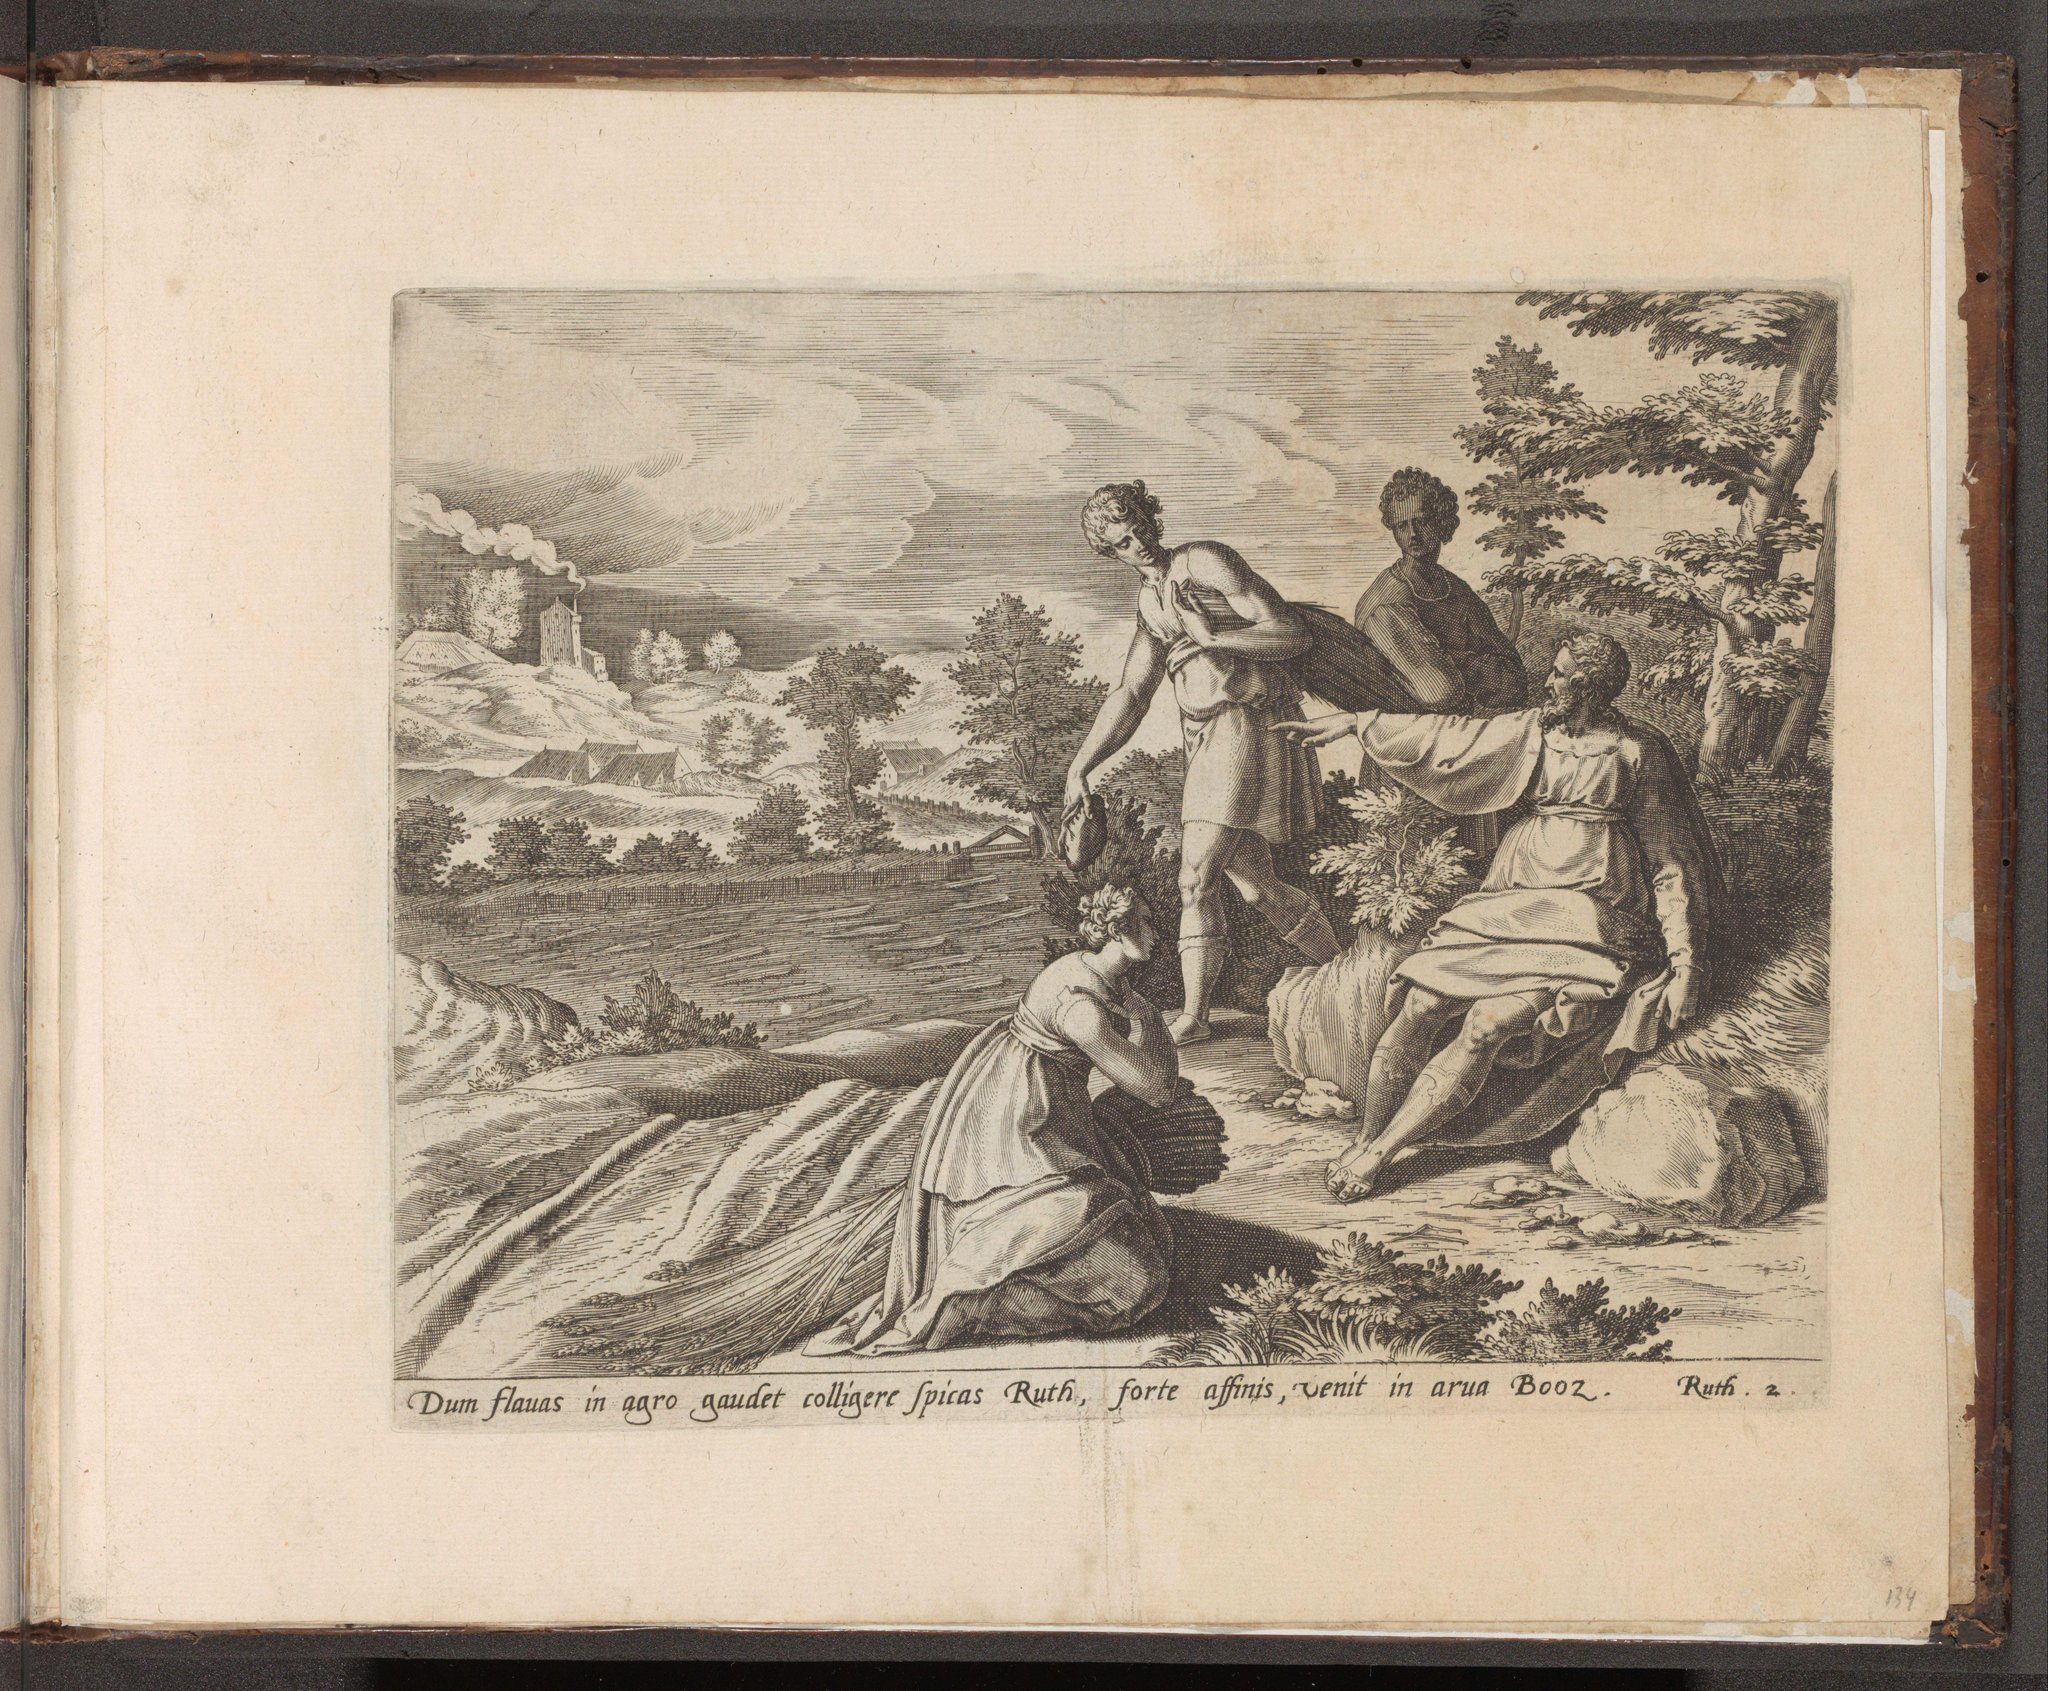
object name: print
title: Ruth knielt voor Boaz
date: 1579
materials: paper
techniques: engraving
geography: antwerp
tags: boaz speaks to ruth; ruth usually bowing down, or kneeling before him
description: Boaz spreekt met Ruth, die op zijn akker aren heeft geraapt. Ruth knielt voor hem met een bundel aren onder de arm. Boaz wijst op zijn akker en zegt dat ze aren mag blijven rapen. Onder de voorstelling een verwijzing in het Latijn naar de Bijbeltekst in Ruth 2. Prent maakt deel uit van een album.